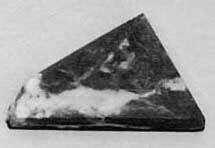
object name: fragment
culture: burmese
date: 1902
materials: jade